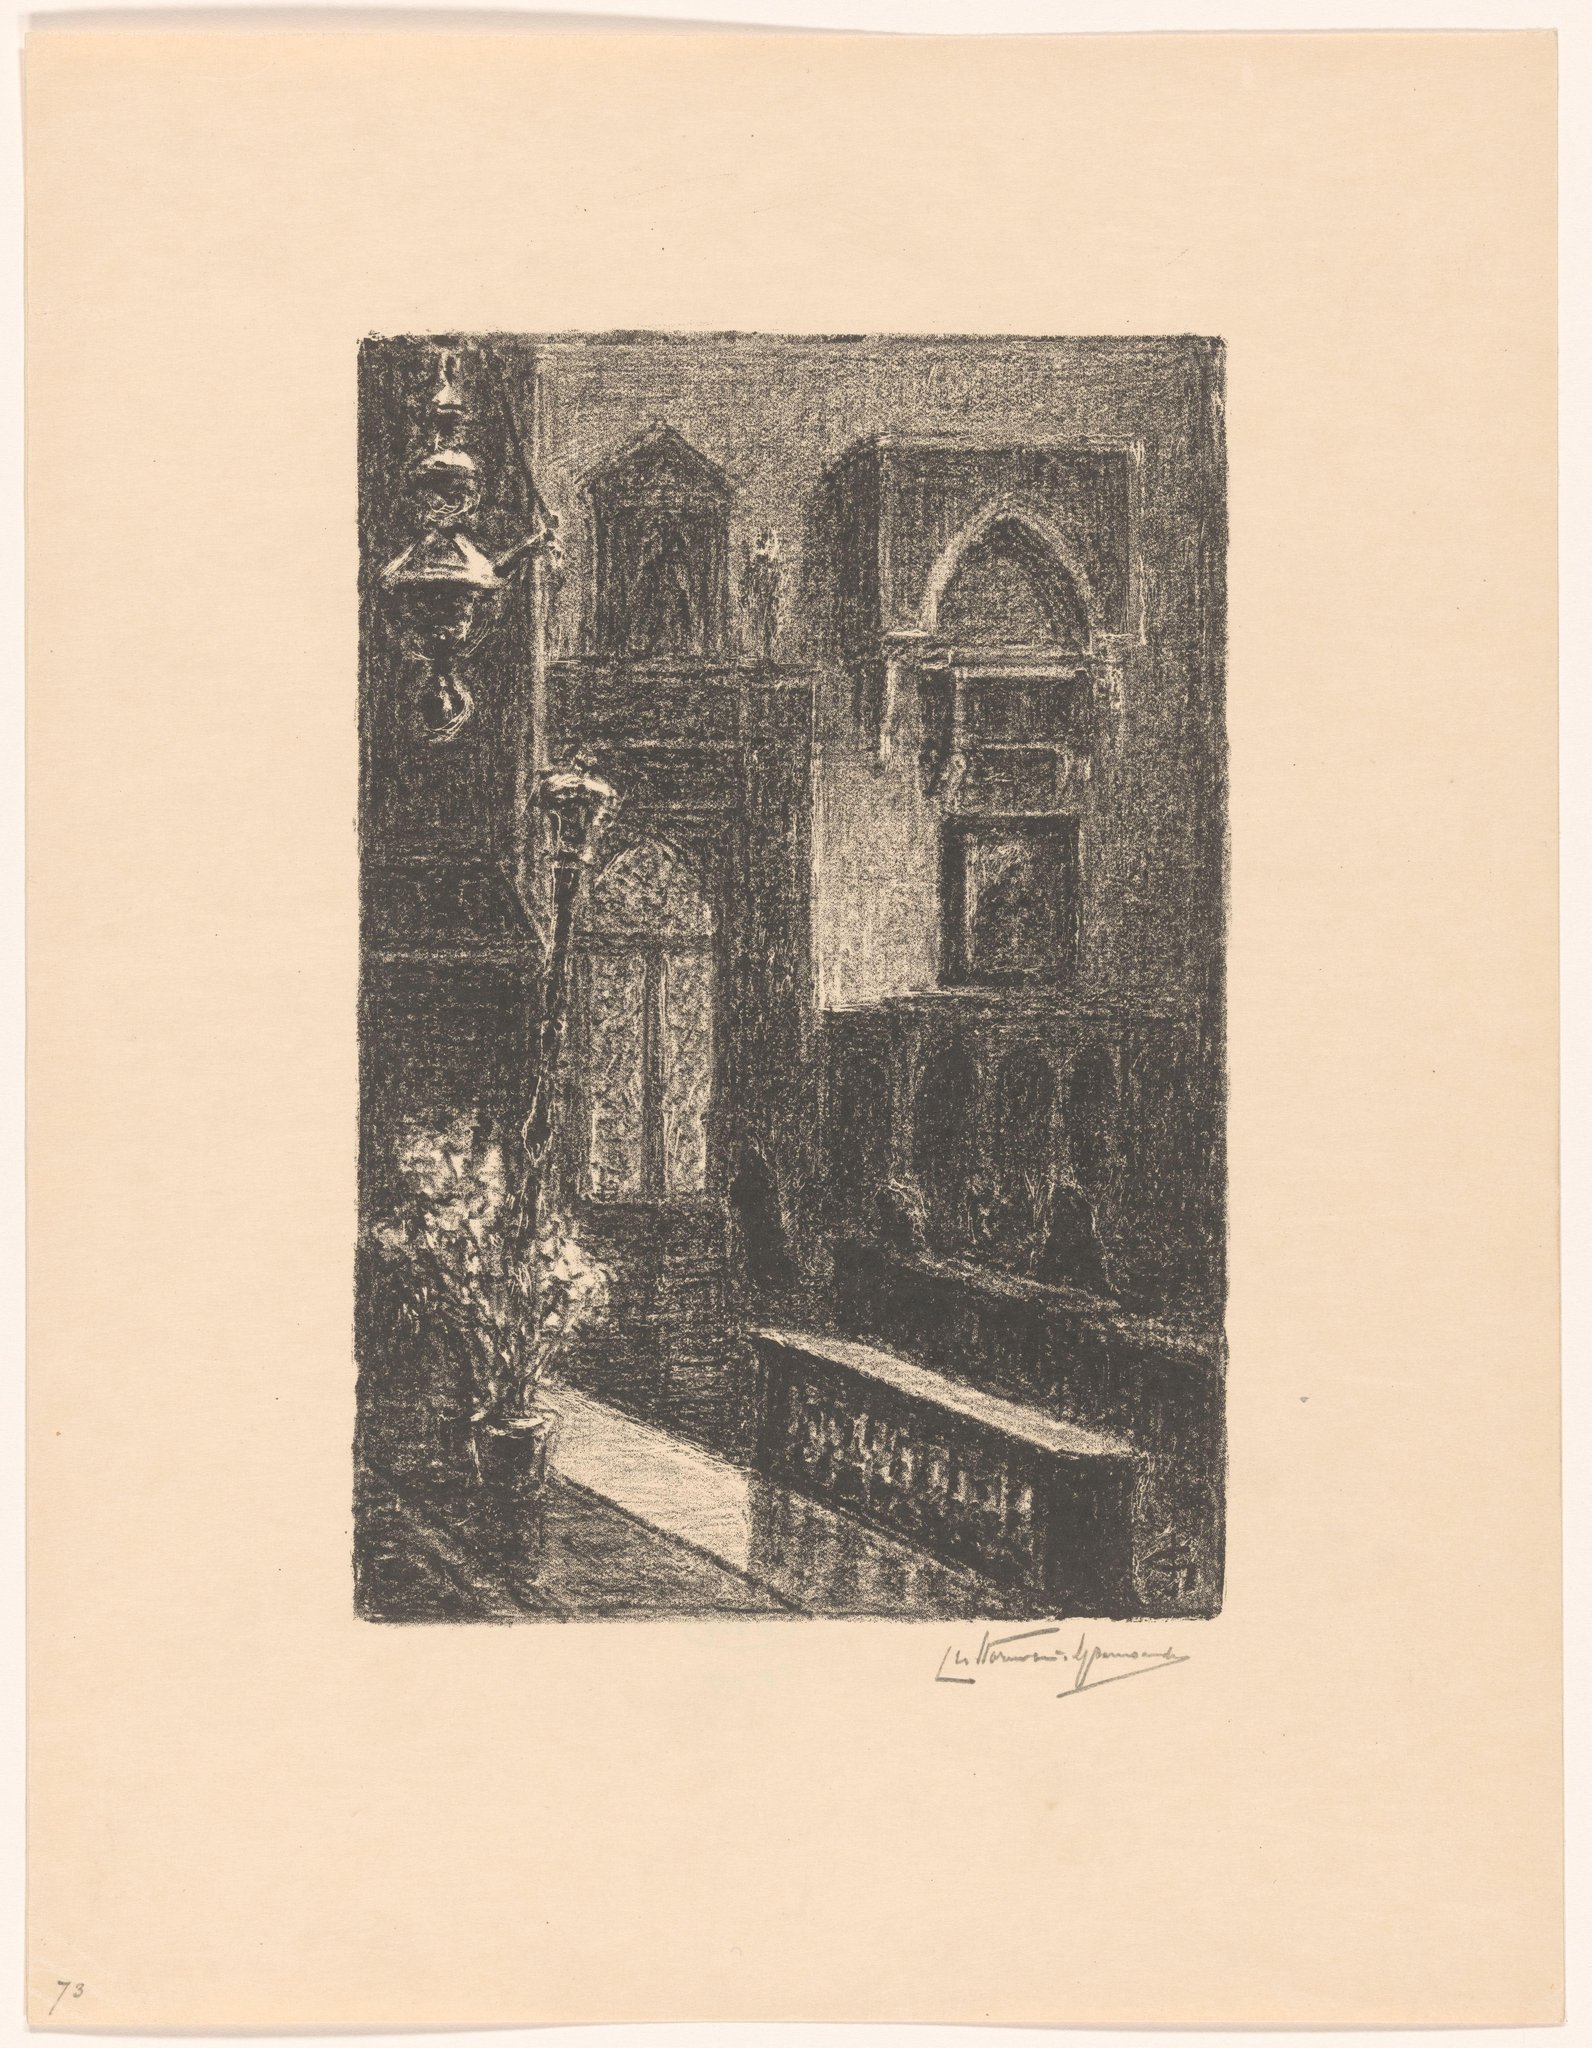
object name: print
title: Kerkinterieur in Venetië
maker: carel nicolaas storm van s-gravesande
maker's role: draughtsman, print maker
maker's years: 1841-1924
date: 1851-1924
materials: paper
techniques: lithograph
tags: interior of church, venice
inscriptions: collector's mark: Lugt 2228, number: ‘73’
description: Mogelijk vermeld in: Storm van 's-Gravesande, Charles. Catalogue des eaux-fortes et lithographies. New York: s.n., 1903, of in een onbekende latere uitgave van het manuscript. Vermoedelijk vermeld als catalogusnummer 73.